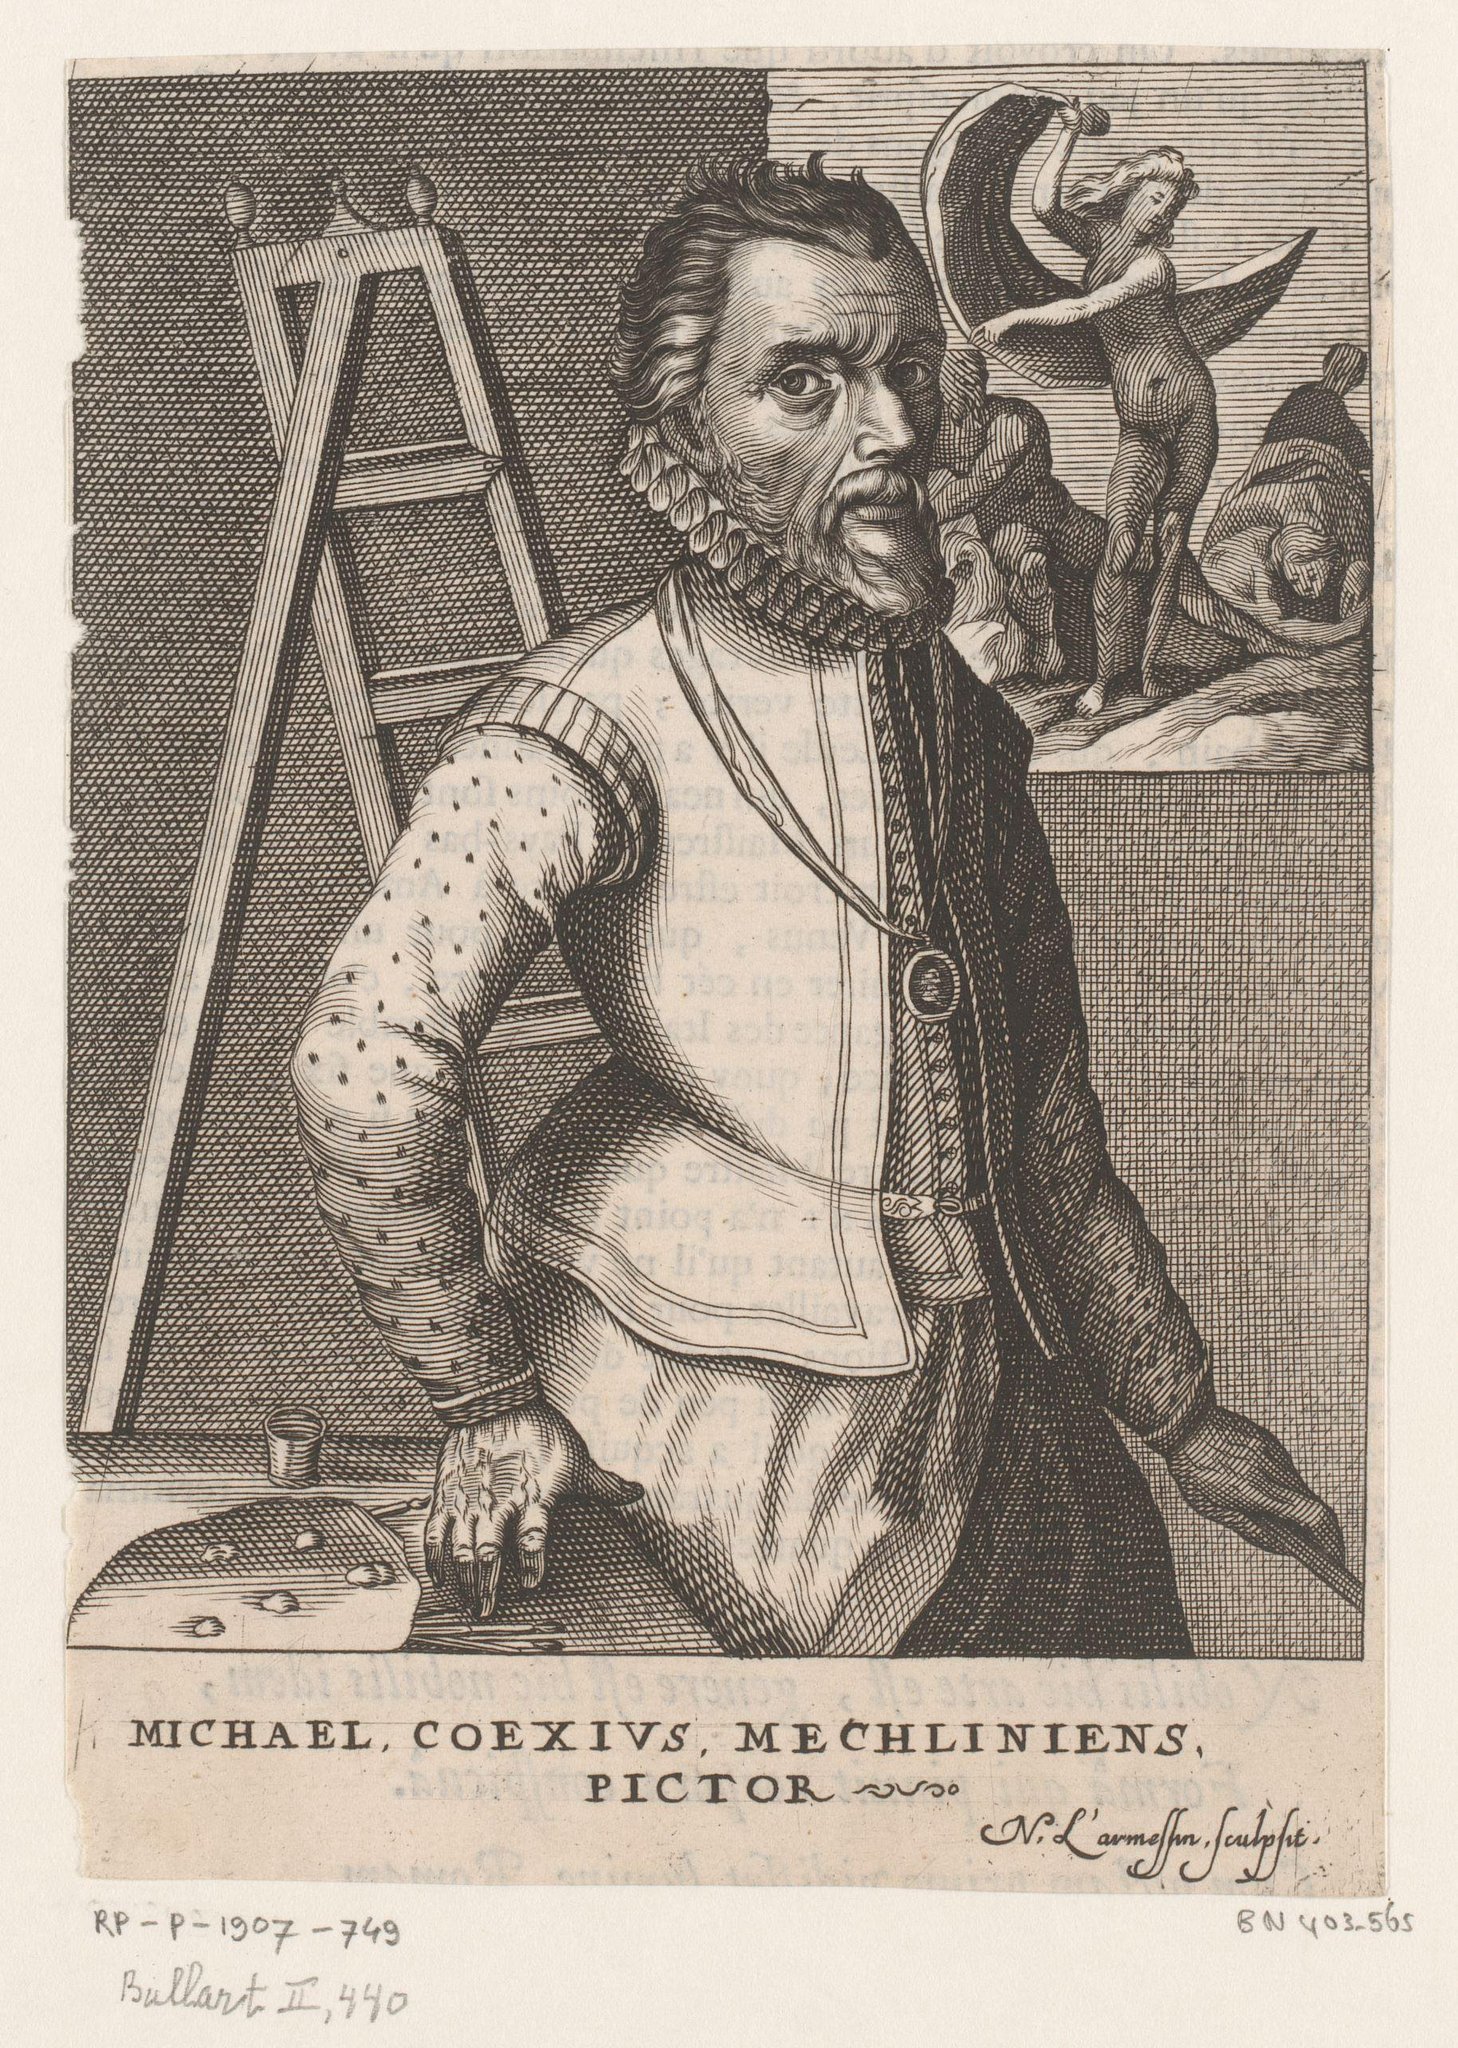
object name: print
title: Michael, Coexius, Mechliniens, Pictor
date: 1682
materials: paper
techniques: engraving, letterpress printing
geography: brussels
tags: mechelen, print maker, draughtsman, michiel coxie (i), historical persons, portrait, self-portrait of artist, workshop, studio of the artist (in general)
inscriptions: collector's mark: Lugt 2228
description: Prent gebruikt voor: Bullart, Isaac. Académie des Sciences et Arts contenant les vies et éloges his. des hommes illustres qui ont excellé en ces professions depuis environ quatre siècles. Brussel: François Foppens, 1682. Het boek werd in 1682 eveneens in Amsterdam uitgegeven door de erfgenamen van Daniel Elzevier. Ieder portret betreft een illustratie bij de biografie van een kunstenaar of geleerde. De meeste portretten werden door Nicolas de Larmessin vervaardigd (162), 93 door De Boulonois en een derde door ongeïdentificeerde prentmakers. Dit betreft een illustratie op p. 440, deel II.